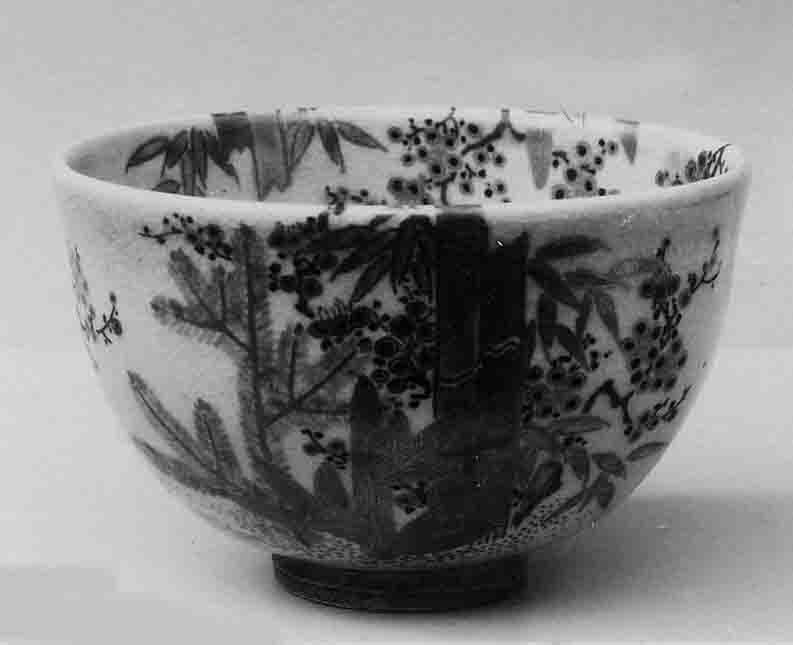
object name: bowl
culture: japanese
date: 1730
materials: enamel, faience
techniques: glazing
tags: bamboo,leaves